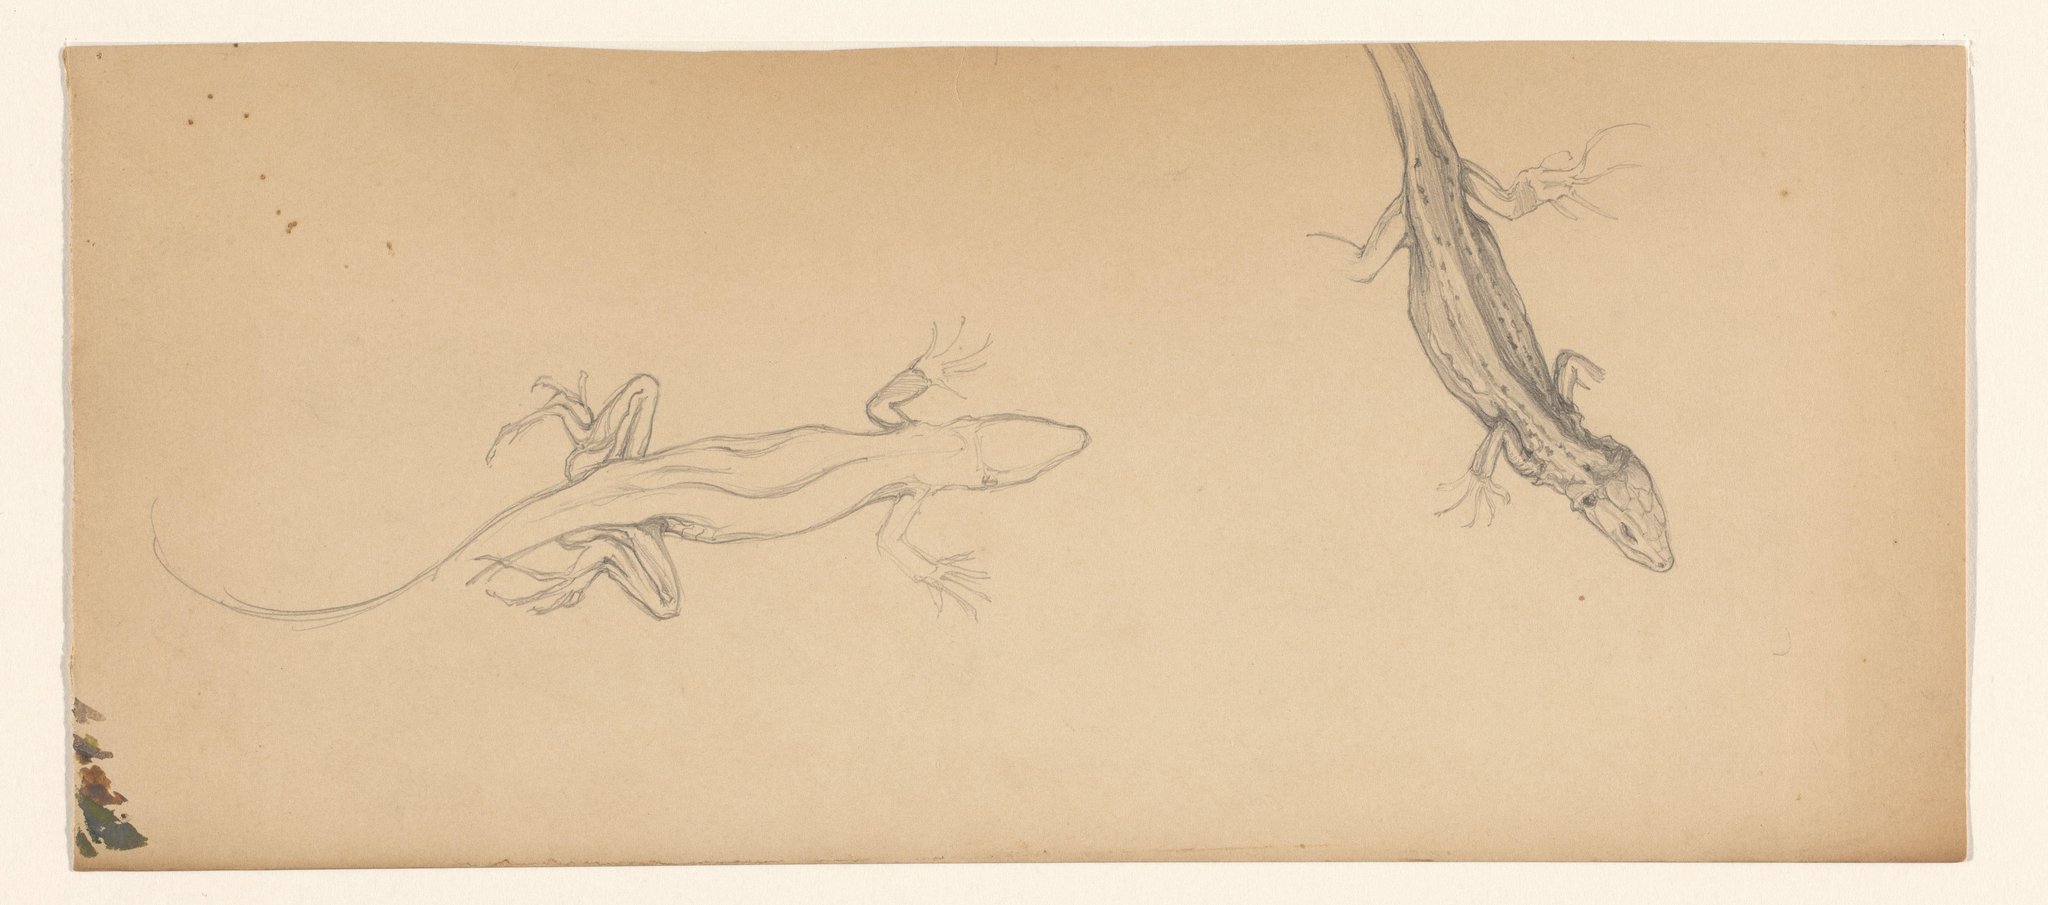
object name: drawing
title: Hagedissen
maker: julie de graag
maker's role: draughtsman, print maker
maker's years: 1877-1924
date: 1887-1924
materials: paper, pencil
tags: lizards: lizard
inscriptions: number: ‘164’, inscription: ‘R.P.’